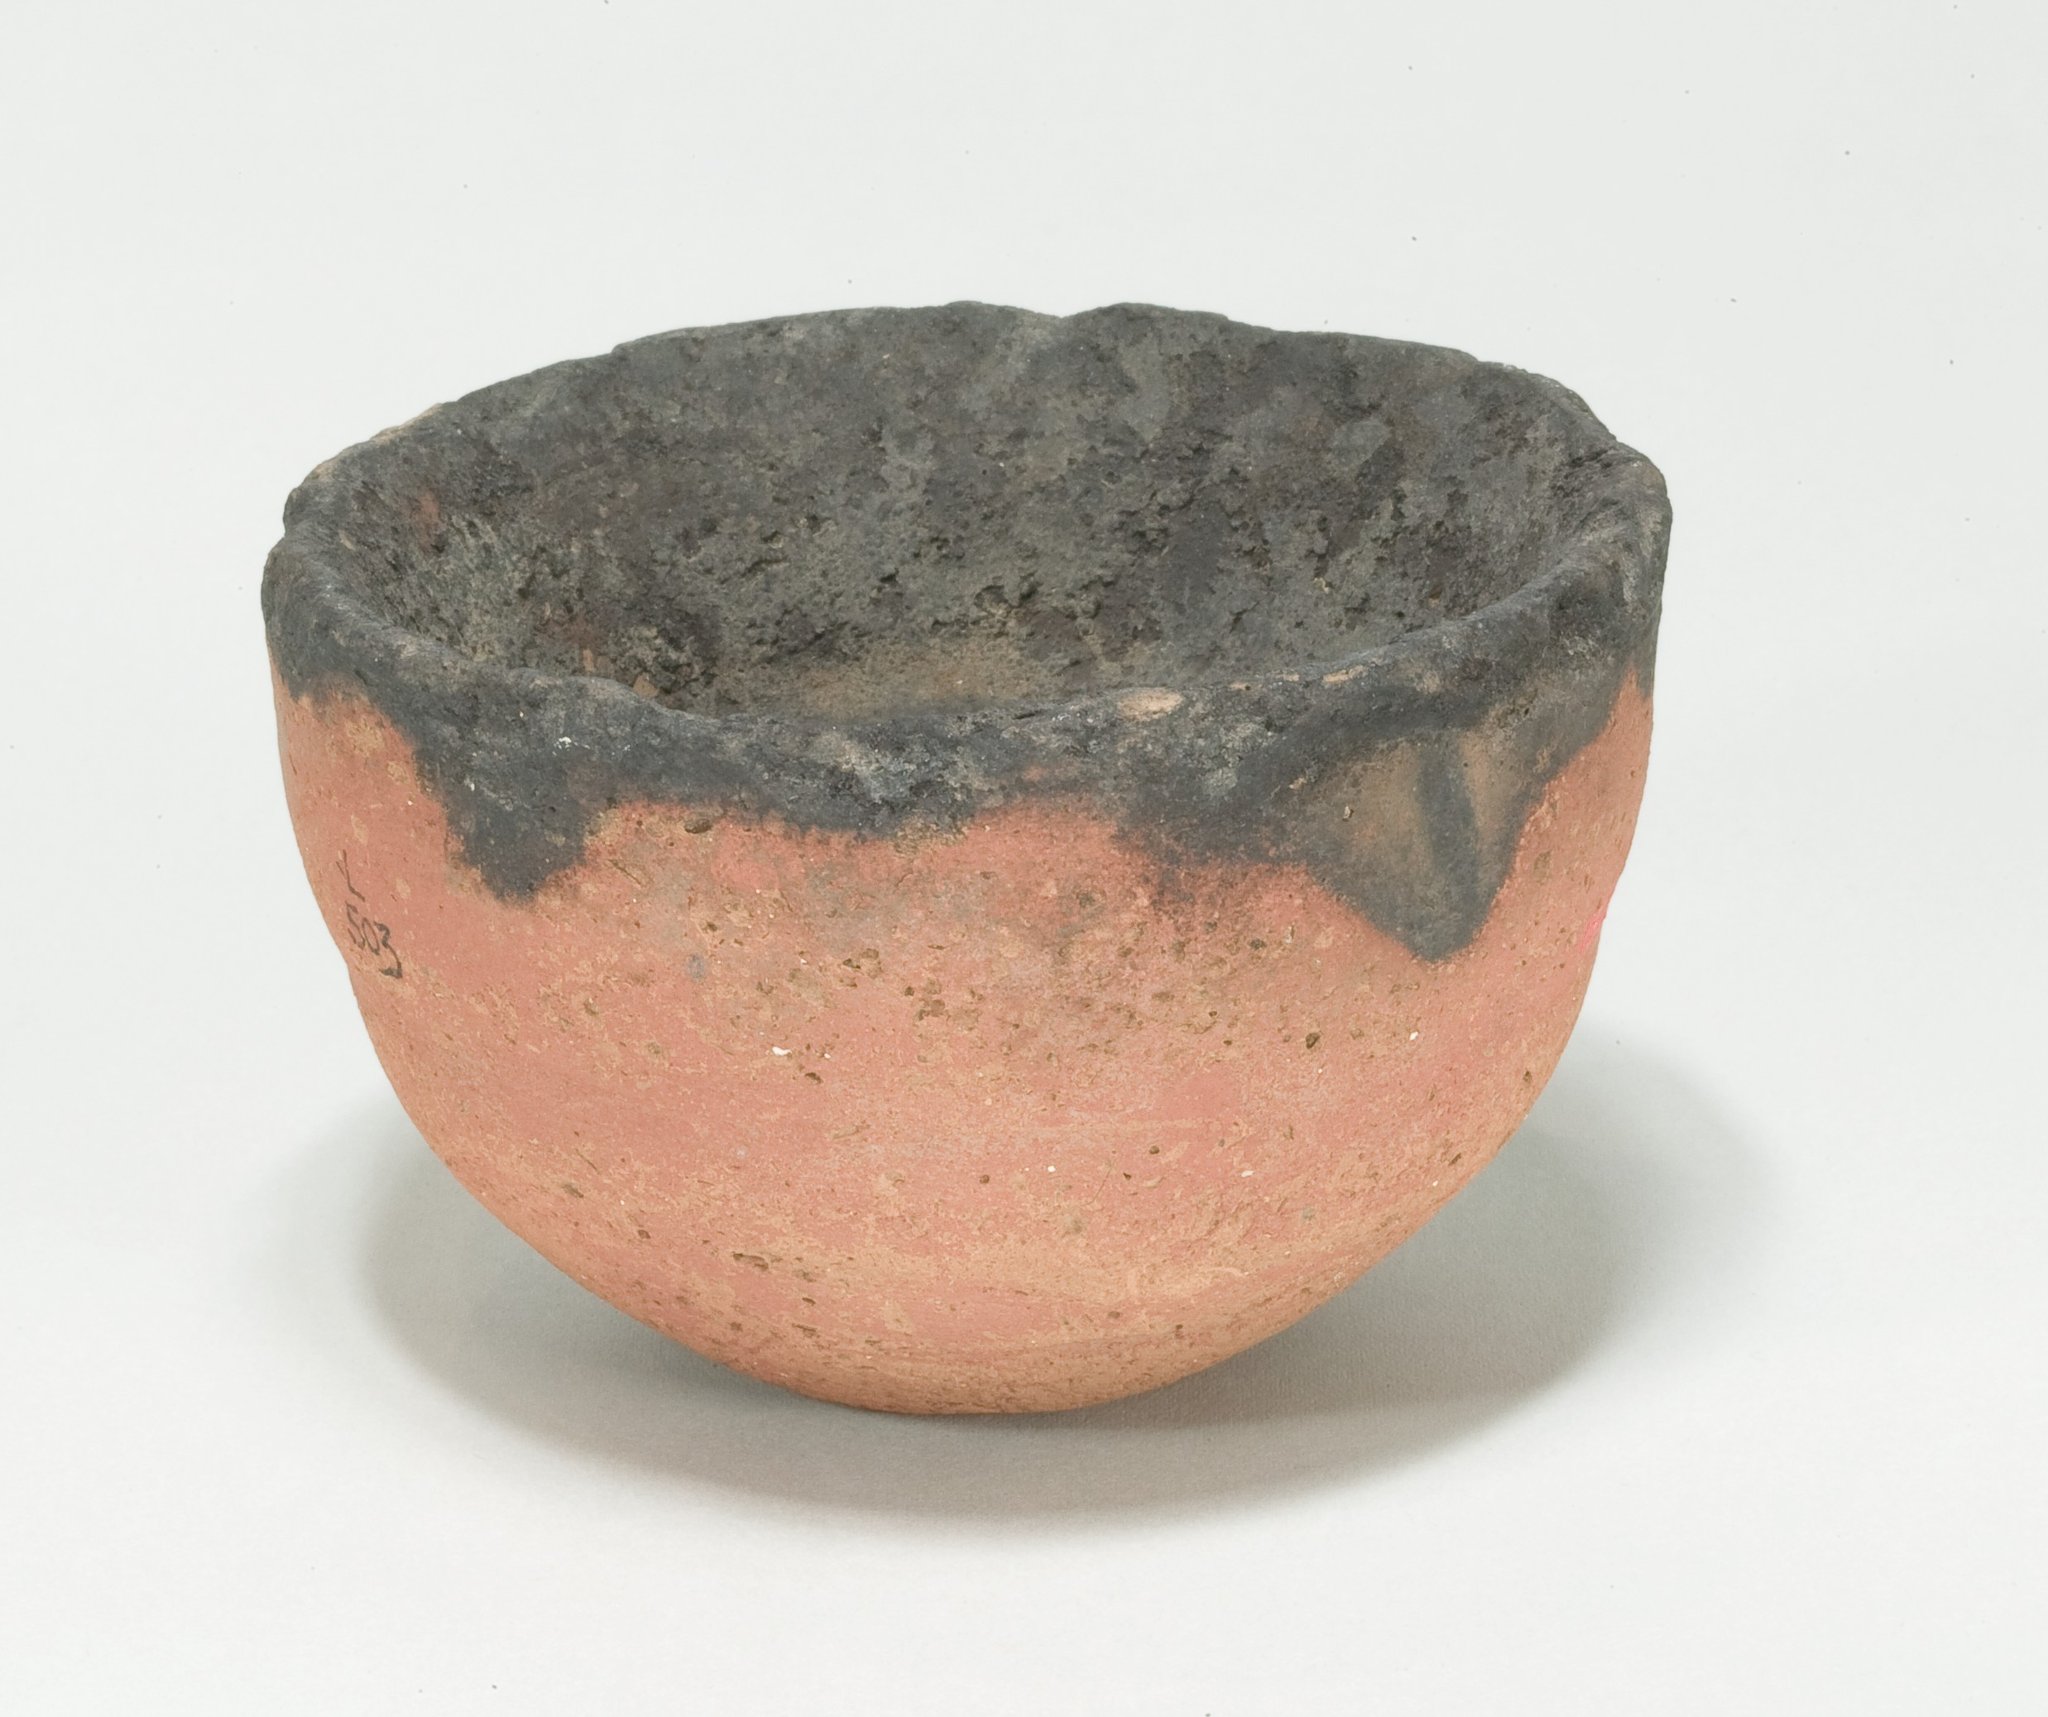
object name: lamp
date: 1950-1550 BCE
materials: mineral, pottery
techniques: wash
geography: egypt